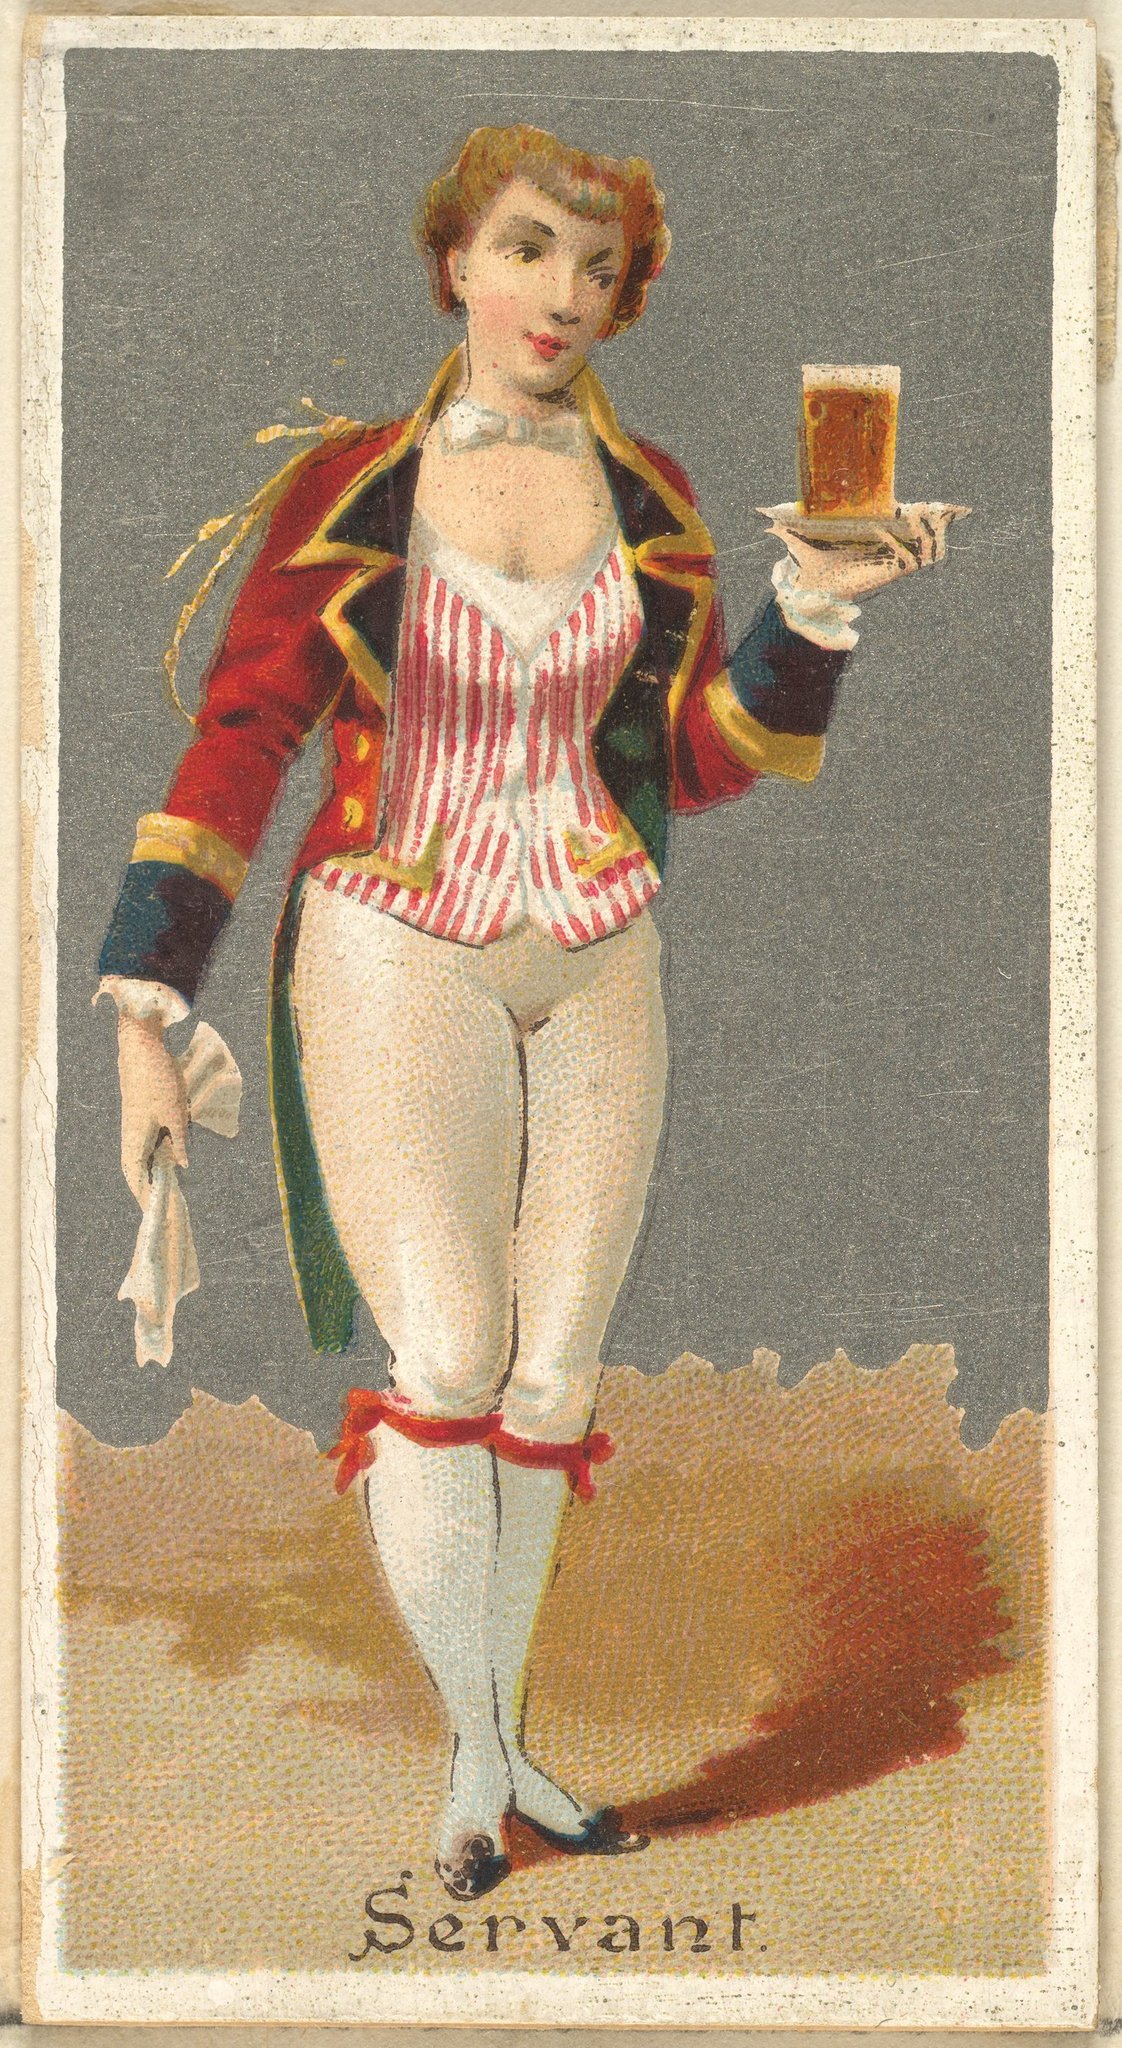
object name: print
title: Servant, from the Occupations for Women series (N166) for Old Judge and Dogs Head Cigarettes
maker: goodwin & company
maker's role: publisher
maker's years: 1850-1950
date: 1887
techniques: color lithograph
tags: women,servants